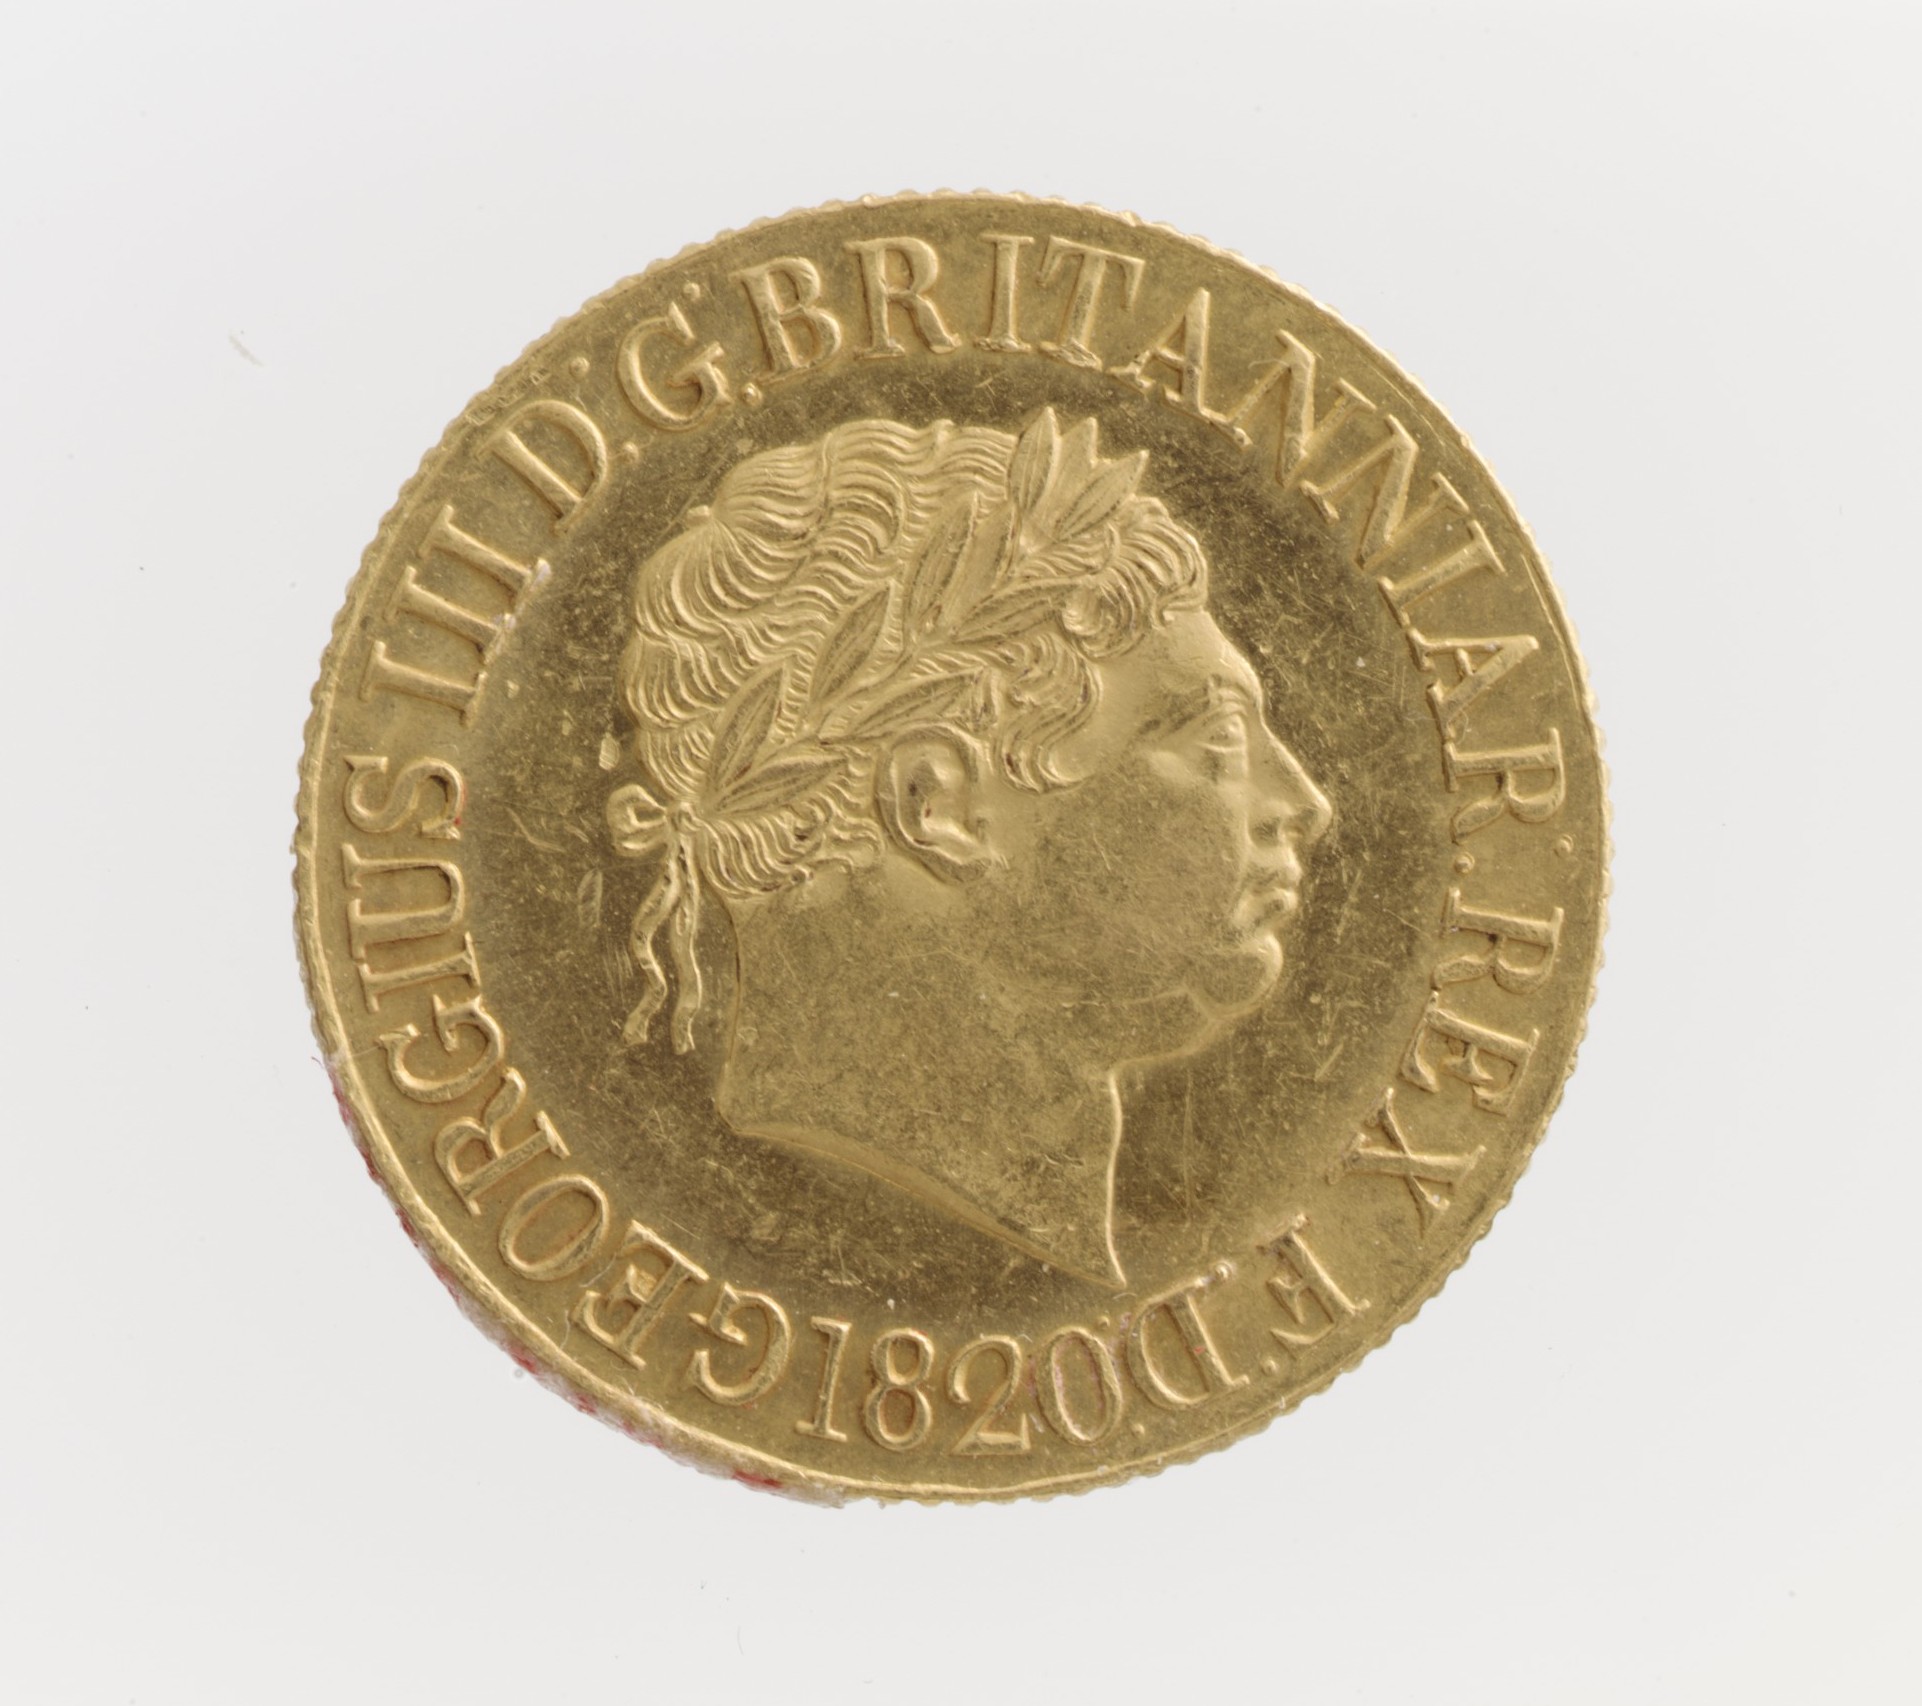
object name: sovereign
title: George III pattern sovereign with St. George reverse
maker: benedetto pistrucci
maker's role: maker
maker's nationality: italian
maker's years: 1783-1855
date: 1820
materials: gold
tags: profiles,horses,saint george